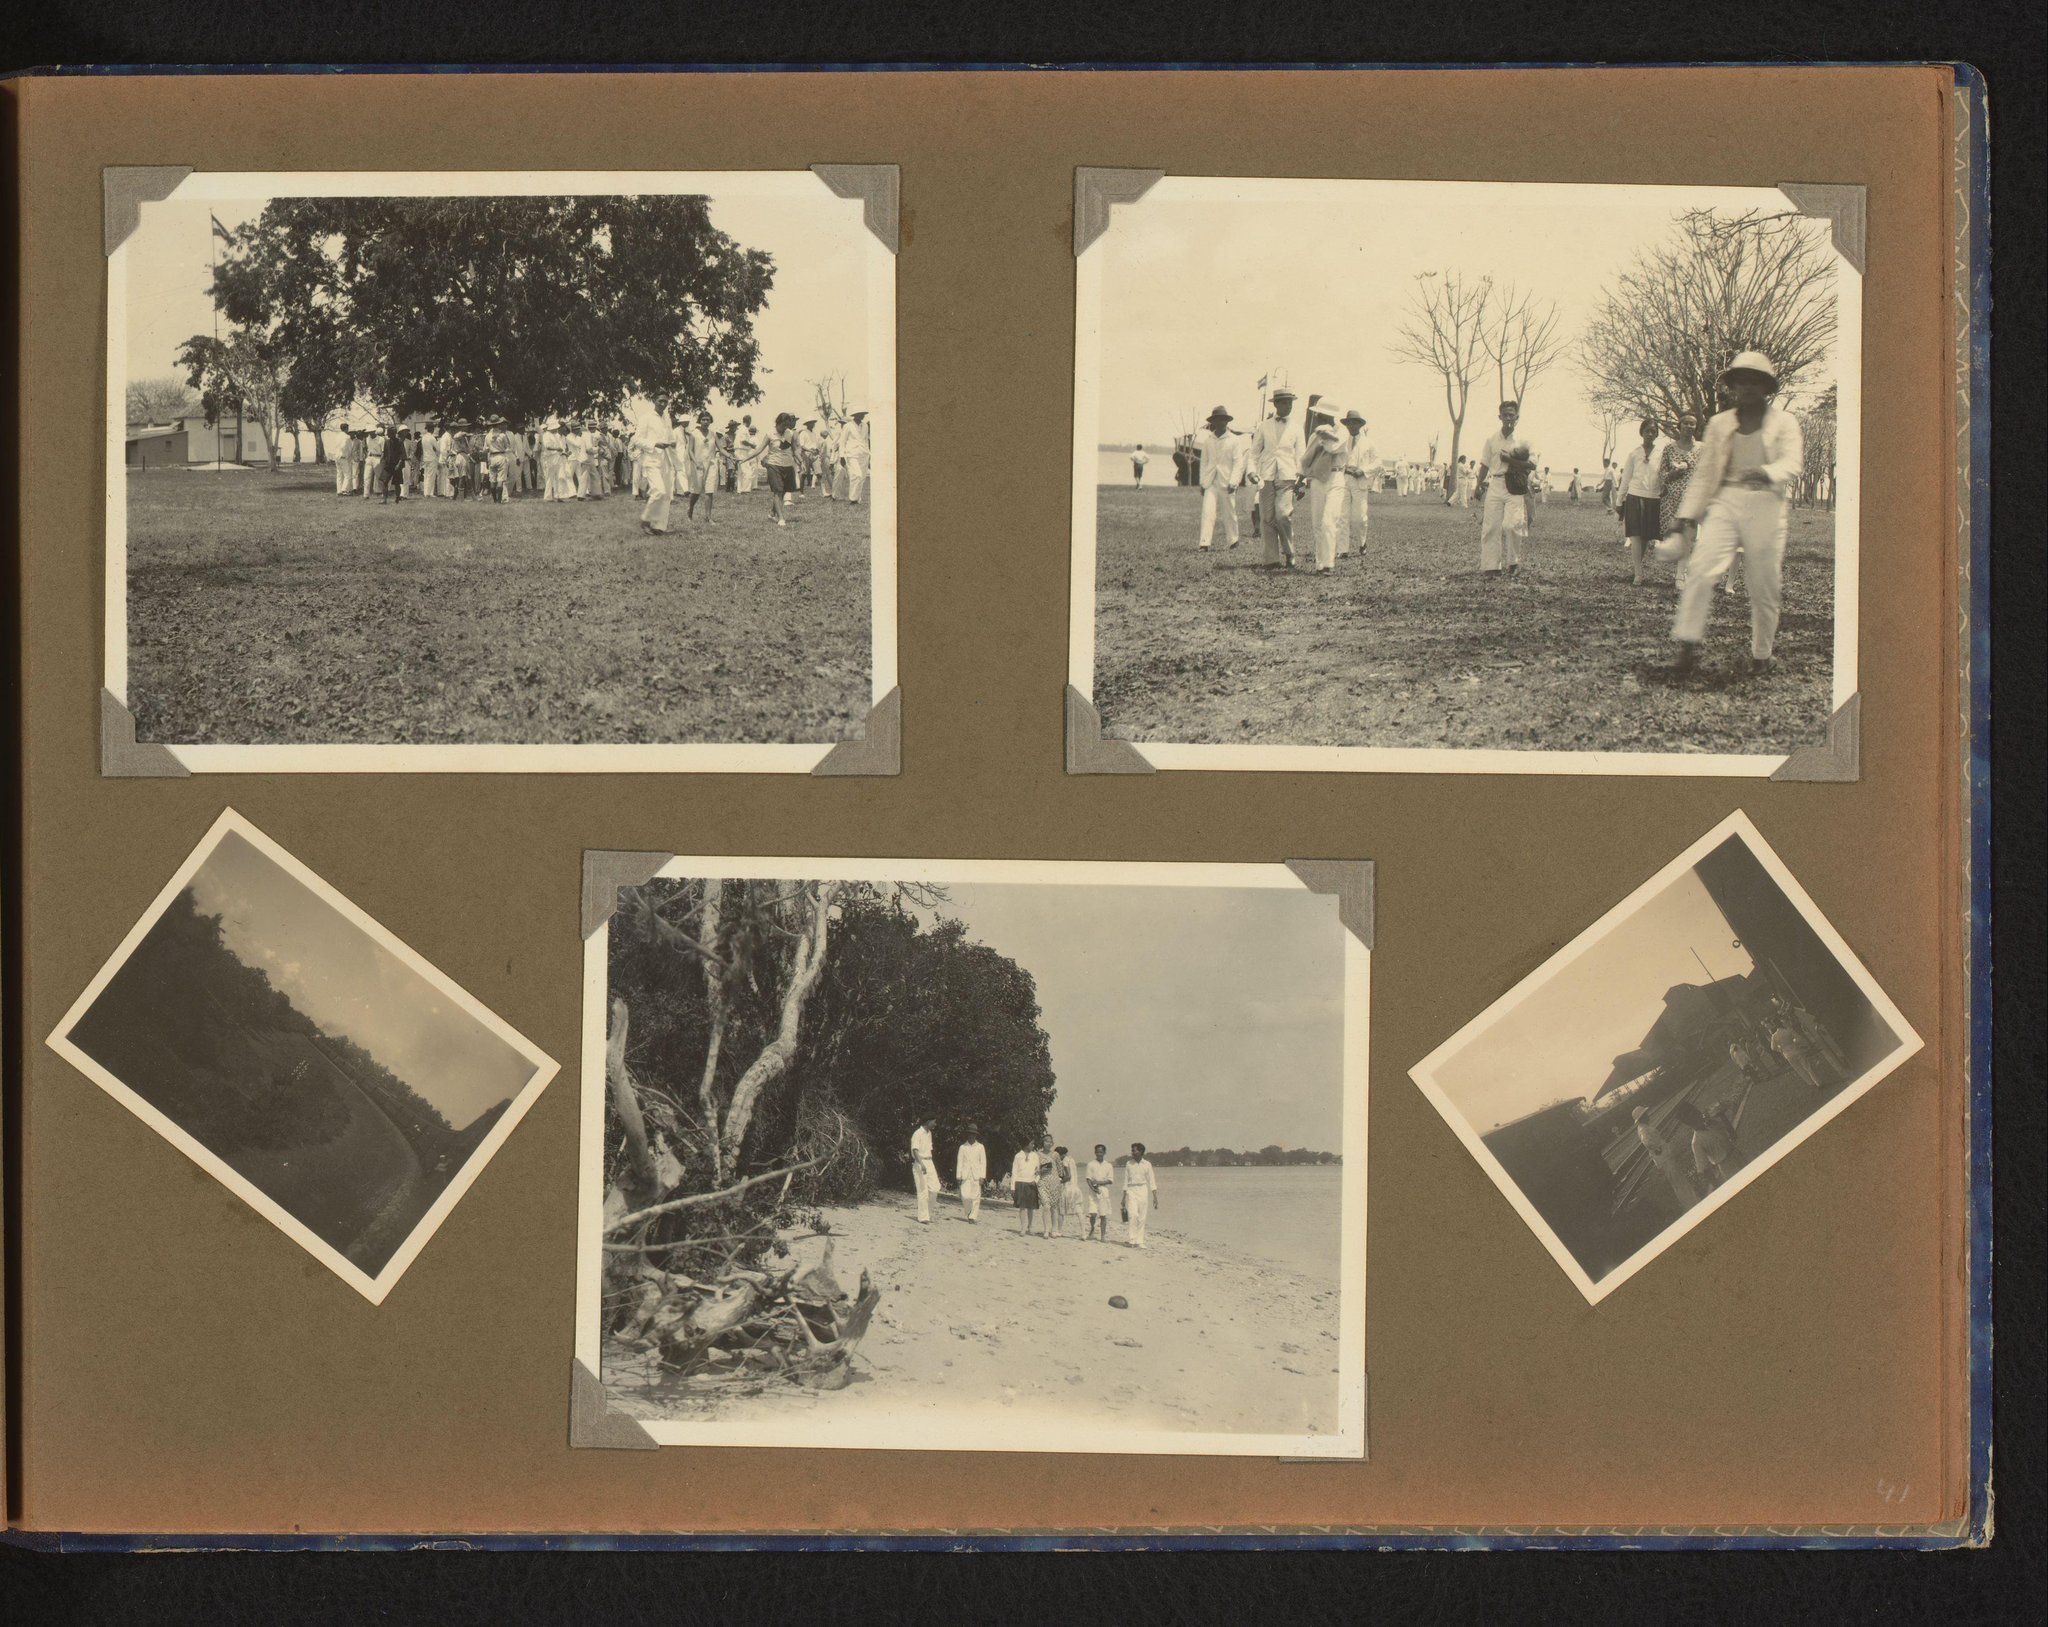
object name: photograph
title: Uitje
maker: Anonymous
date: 1935-1936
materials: cardboard, photographic support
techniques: gelatin silver print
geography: indonesia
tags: outing, pleasure trip, indonesia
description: Albumblad met vijf foto's van een reis door een groep jongen, Mogelijk gaat het om een excursie door leden van de Chung Hsiok vereniging. Onderdeel van een familiealbum van een Chinees-Indische familie in Weltevreden, ca. 1935.